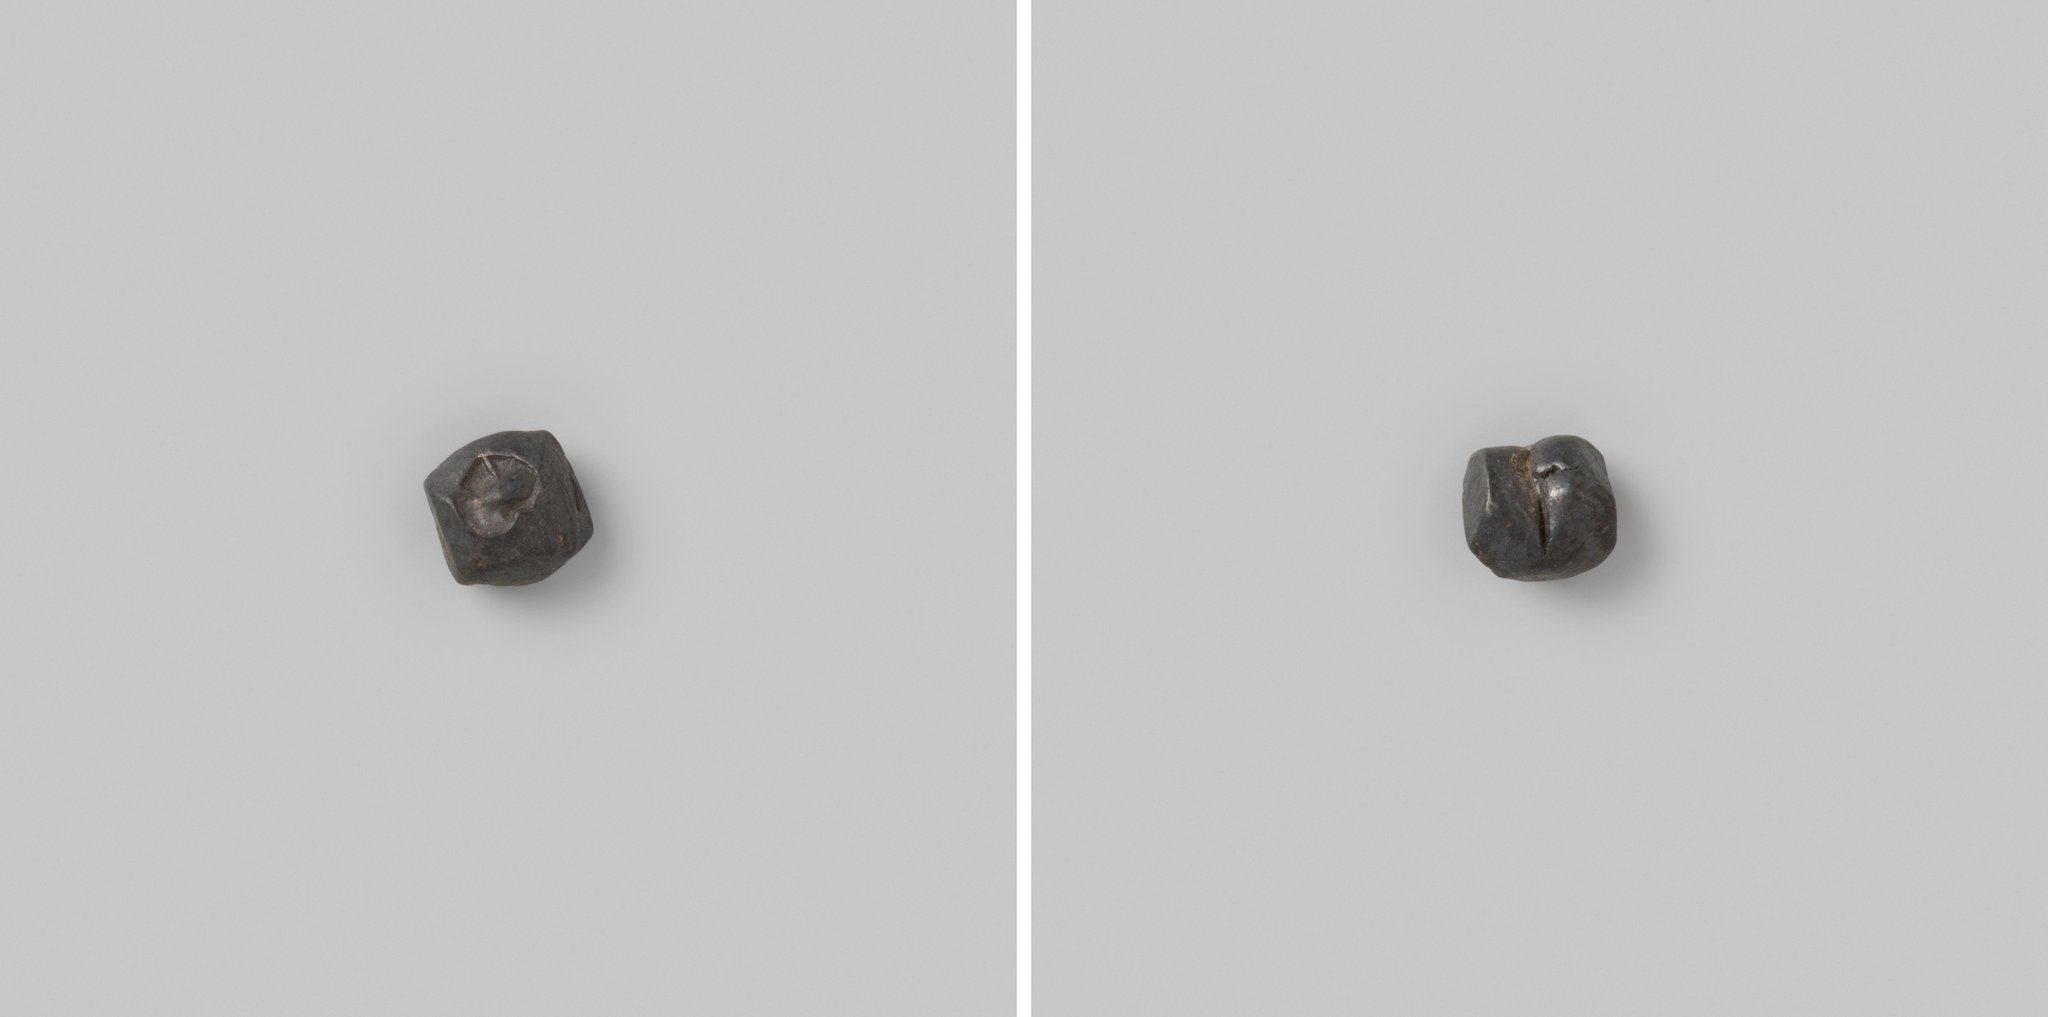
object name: coin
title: 1/32 tical of pai uitThailand,1650-1850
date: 1650-1850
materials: silver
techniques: casting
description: Zilveren, korrelvormige munt. voorzien van één instempeling (kra): water pot [?].